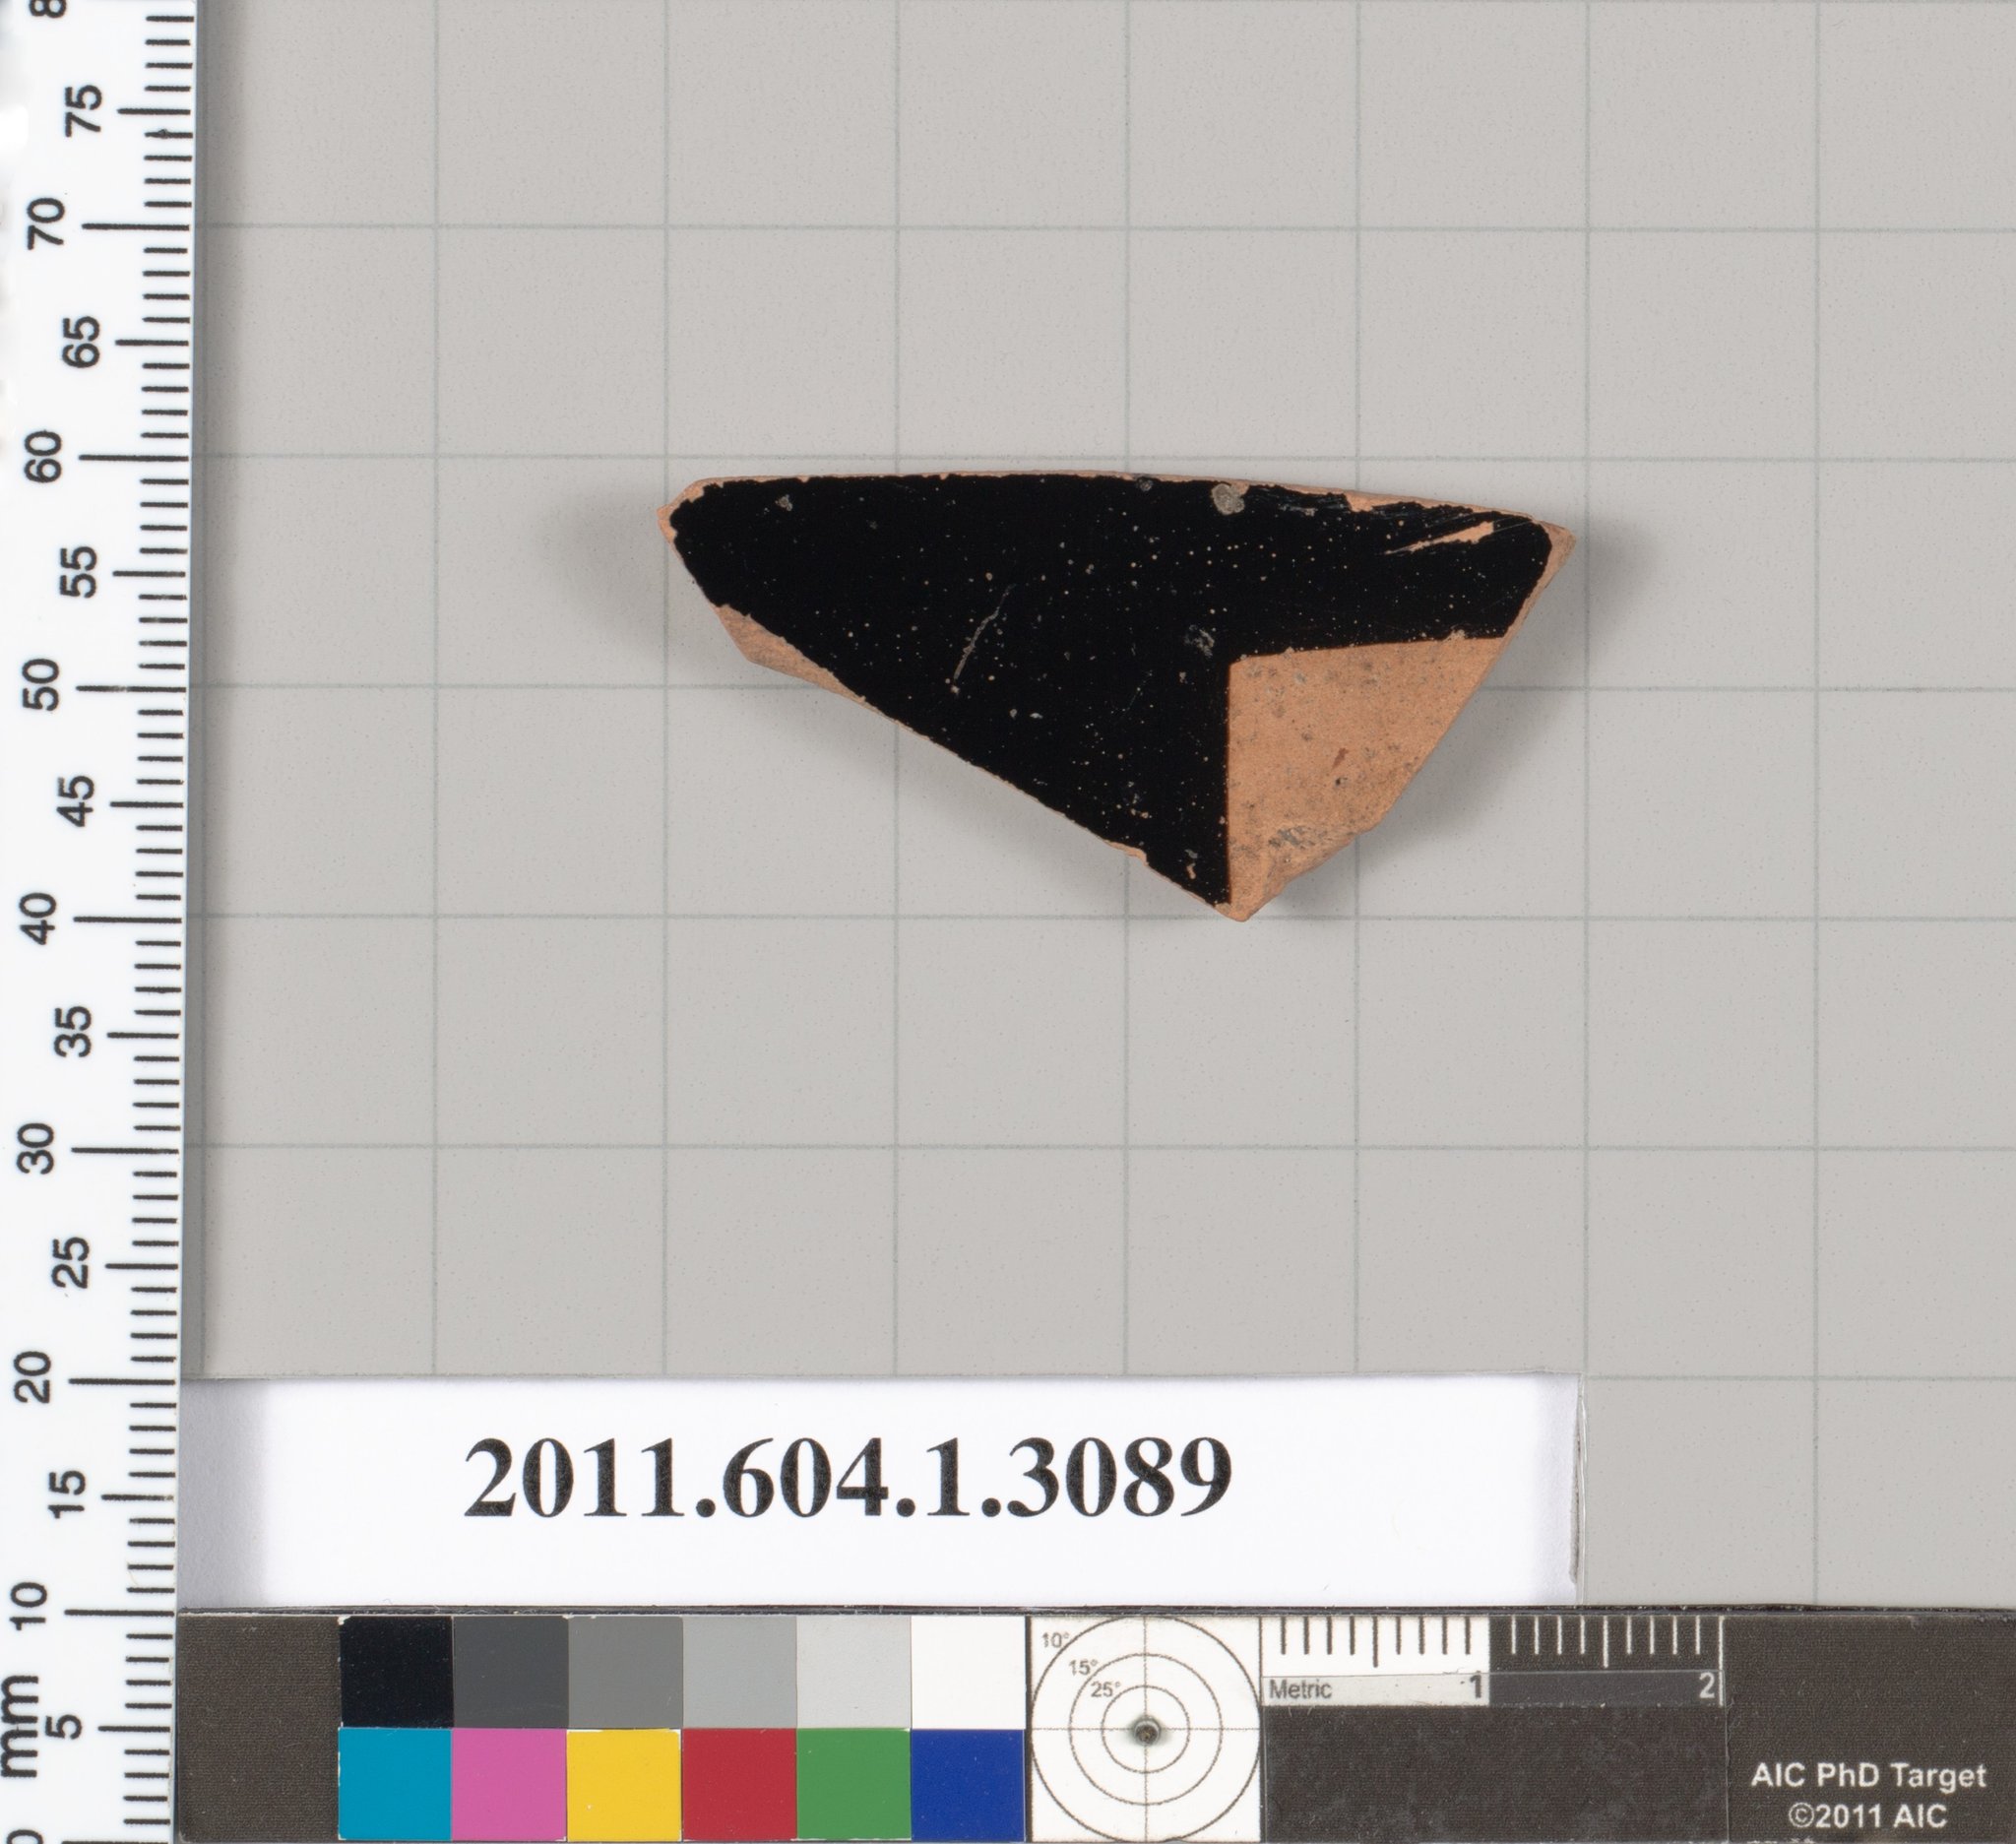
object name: kylix fragment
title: Terracotta fragment of a kylix (drinking cup)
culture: greek, attic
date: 500-451 BCE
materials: terracotta